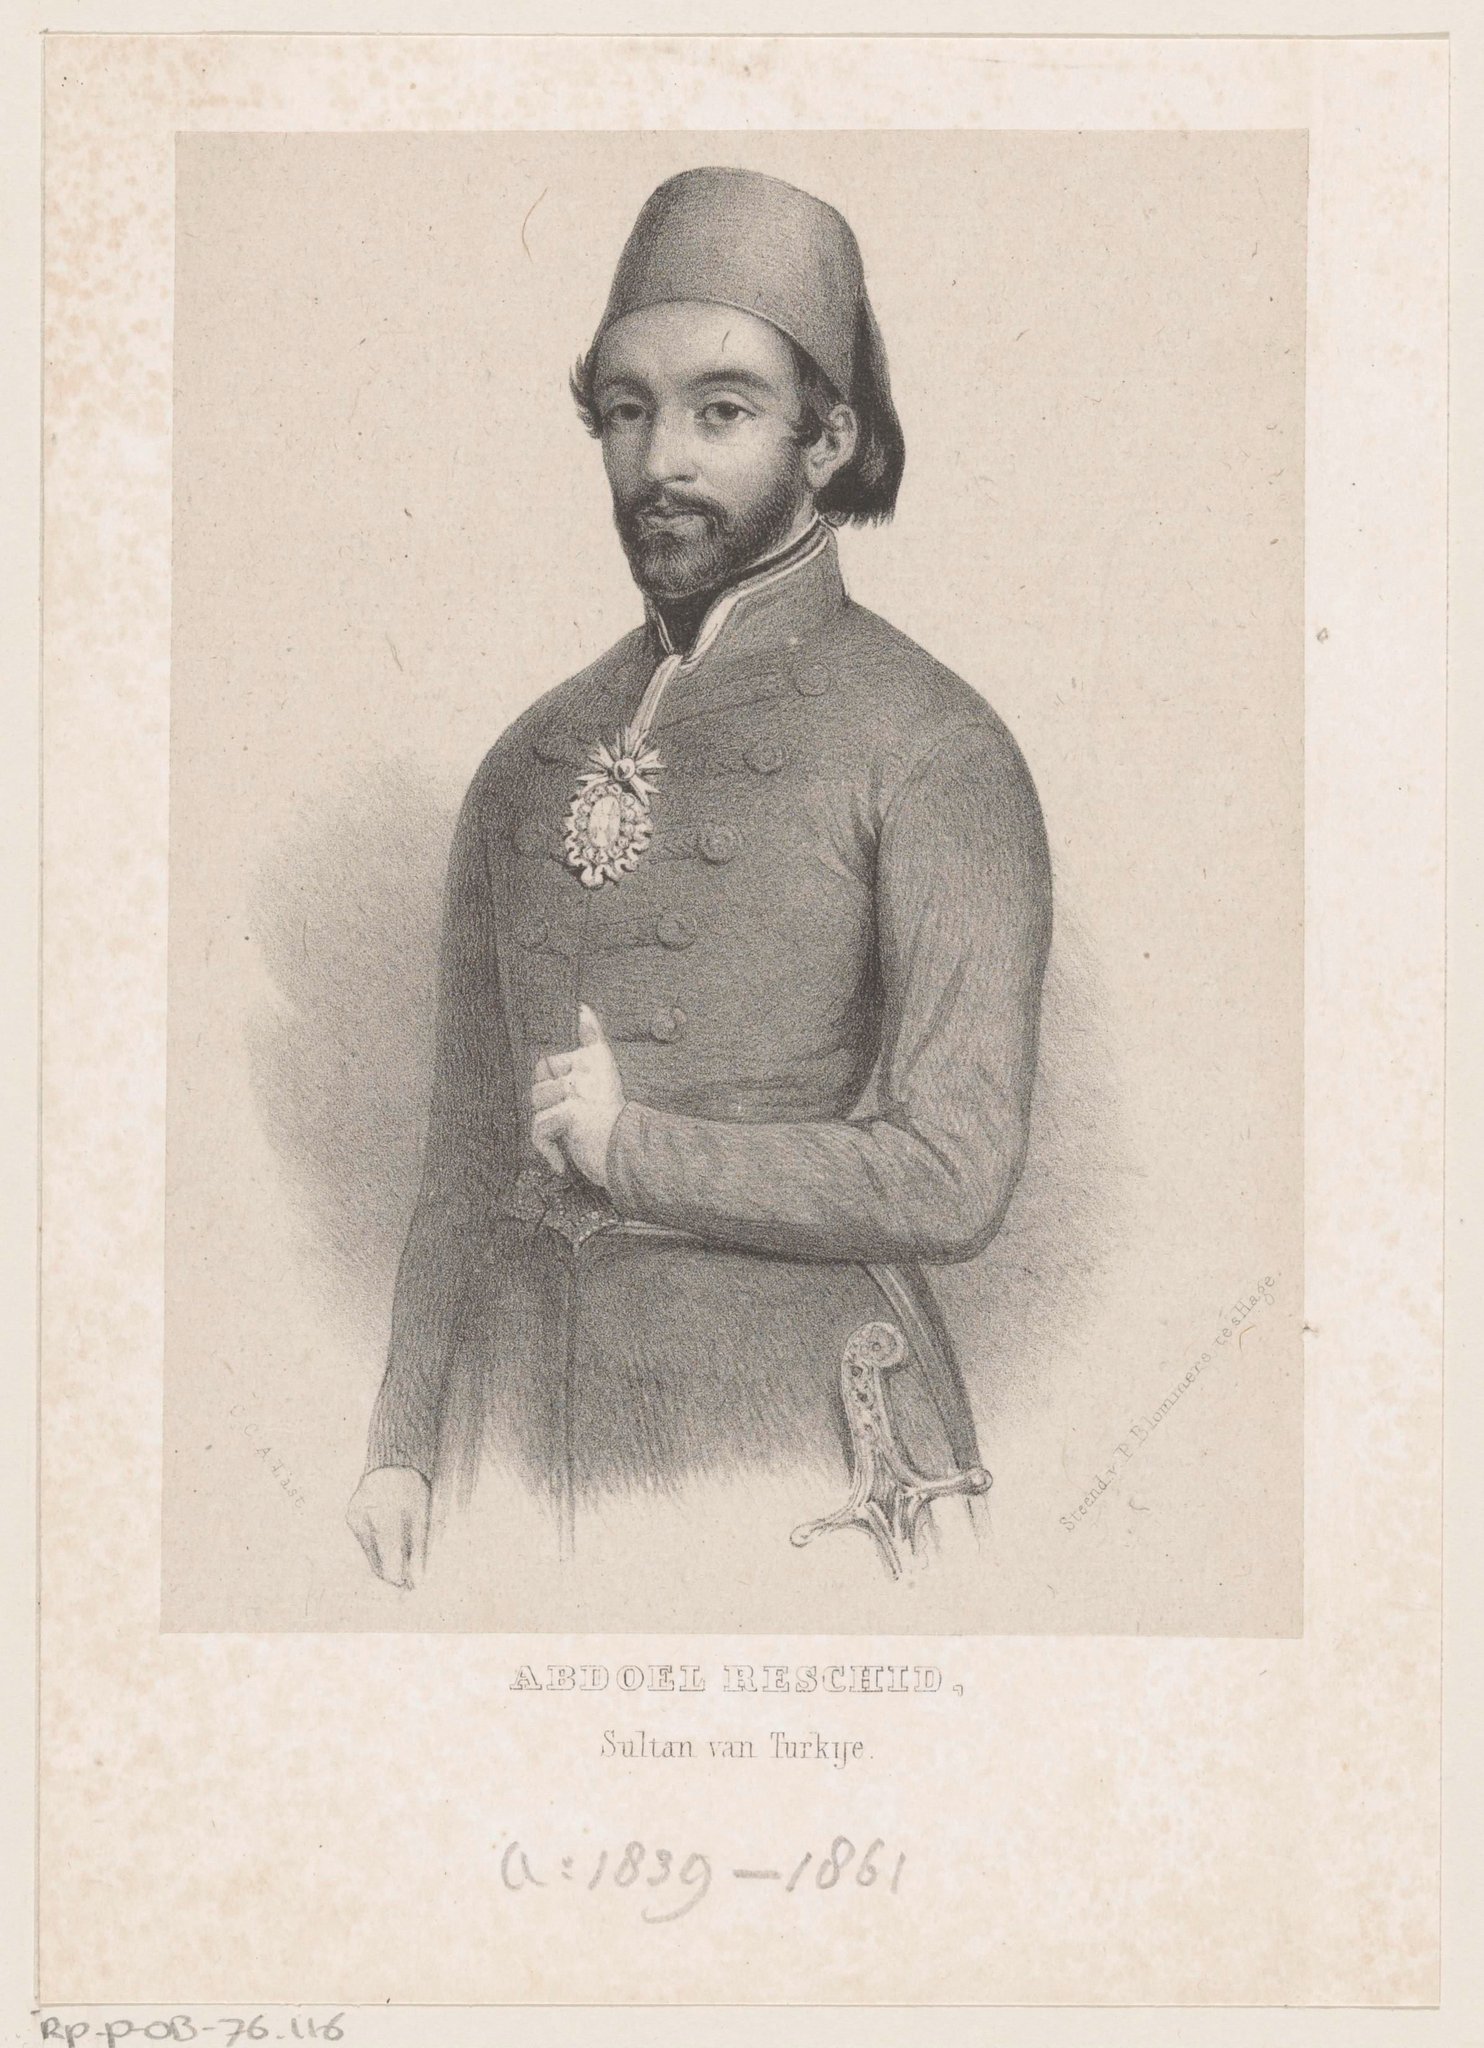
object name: print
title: Portret van Abdülmecit I, sultan van het Ottomaanse Rijk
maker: carel christiaan antony last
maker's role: print maker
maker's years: 1808-1876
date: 1842-1887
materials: paper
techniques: lithograph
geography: netherlands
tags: constantinopel, sultan, abdülmecit i (sultan van het ottomaanse rijk)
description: Portret van Abdülmecit I. In de ondermarge zijn naam en titel.